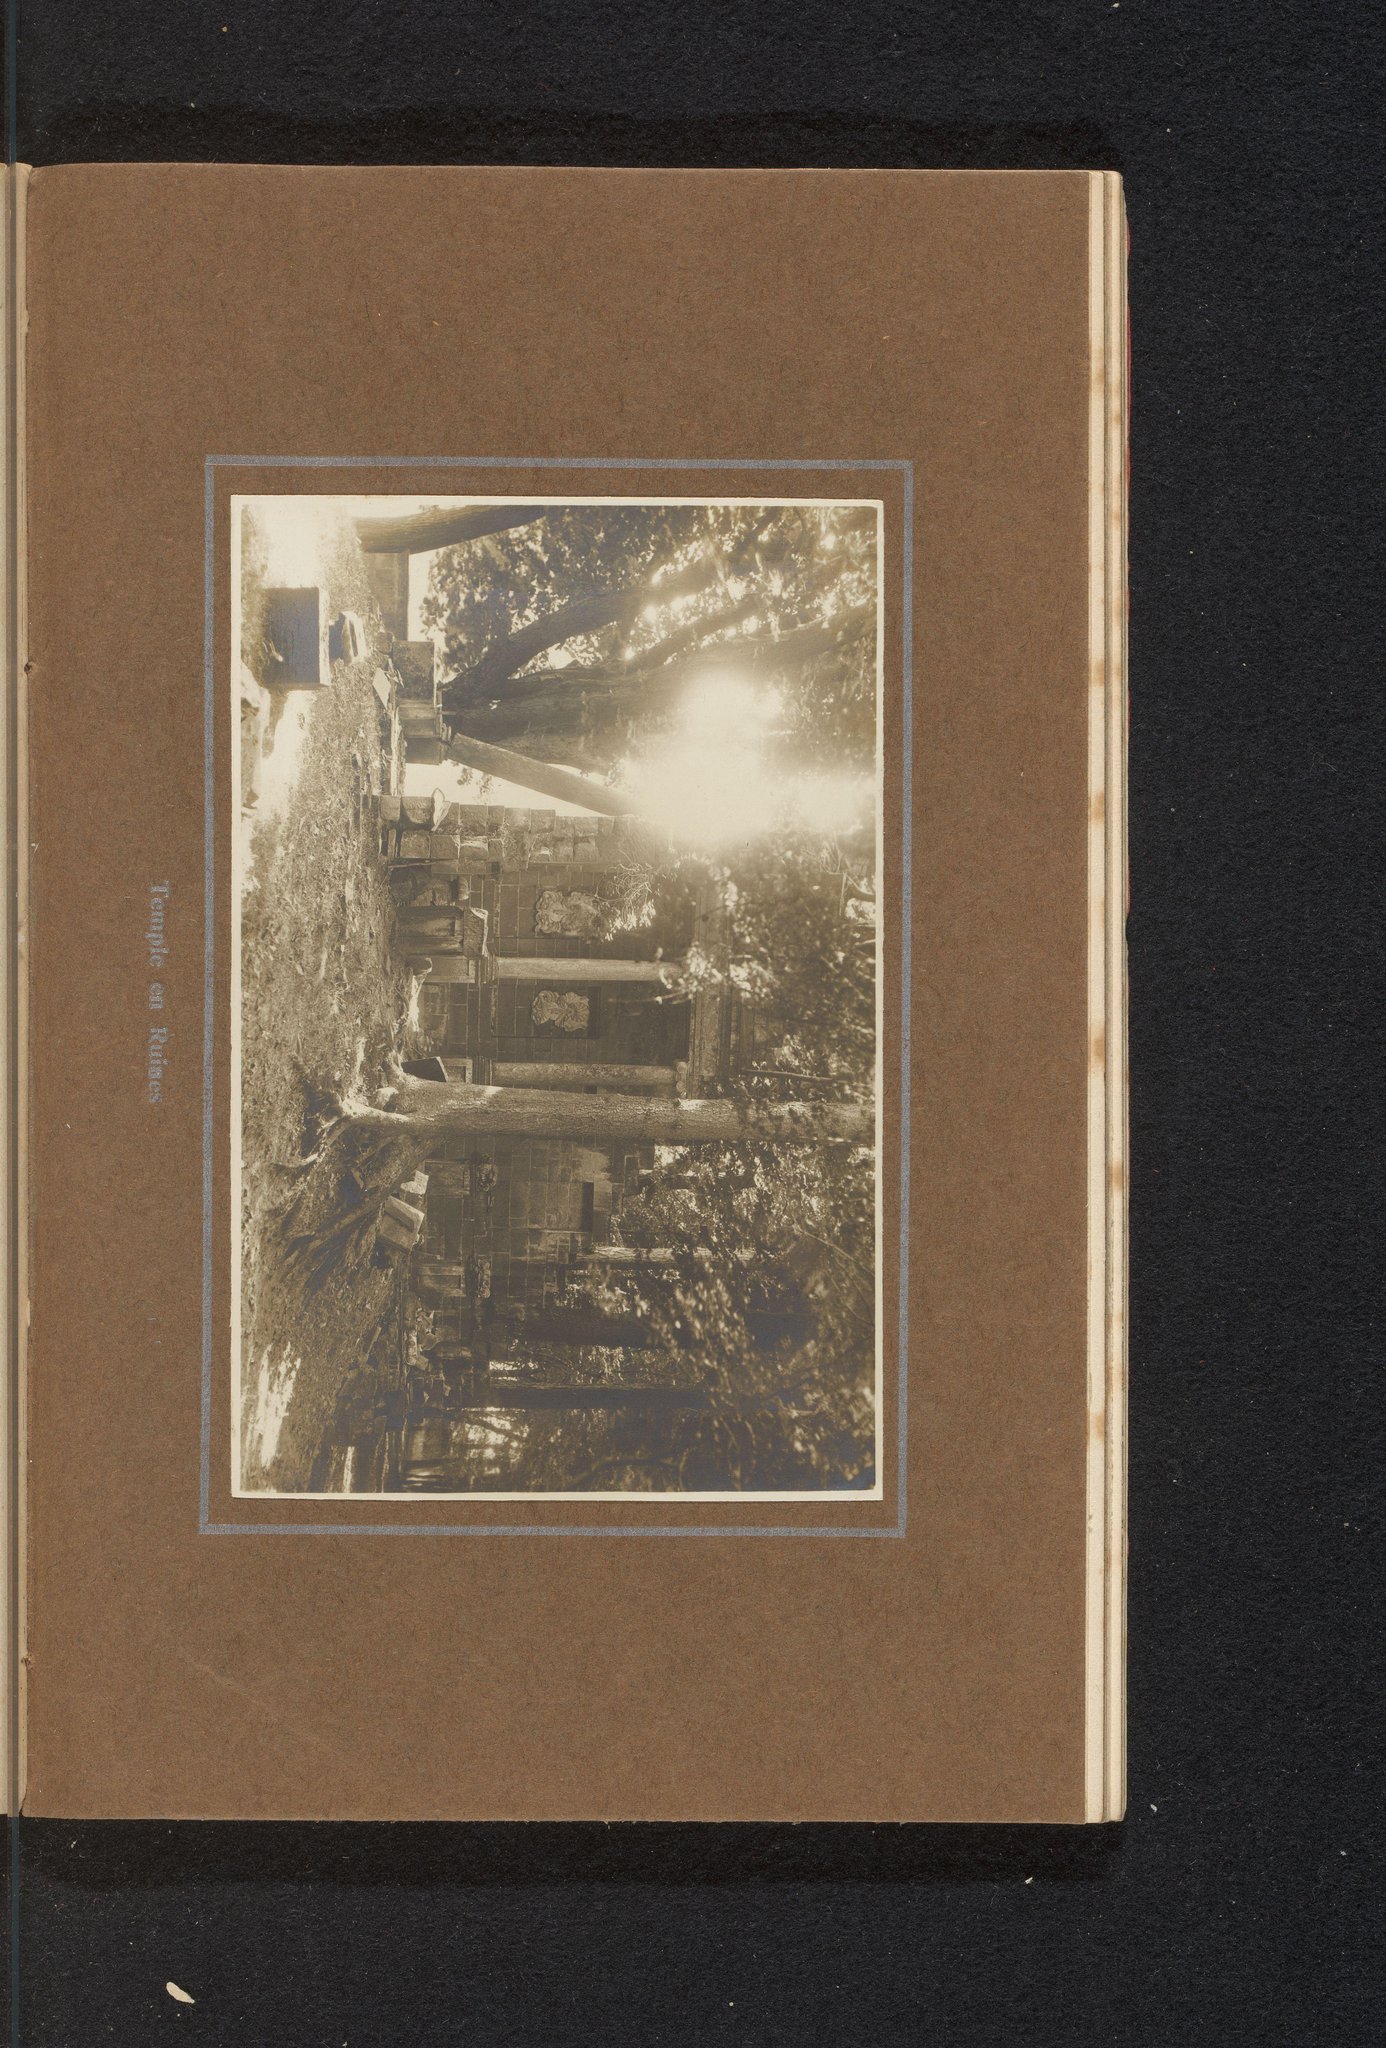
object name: page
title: Temple en Ruines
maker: coppin-goisse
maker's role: printer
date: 1907-1912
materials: photographic support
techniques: gelatin silver print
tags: trees, ruin of a building ~ architecture